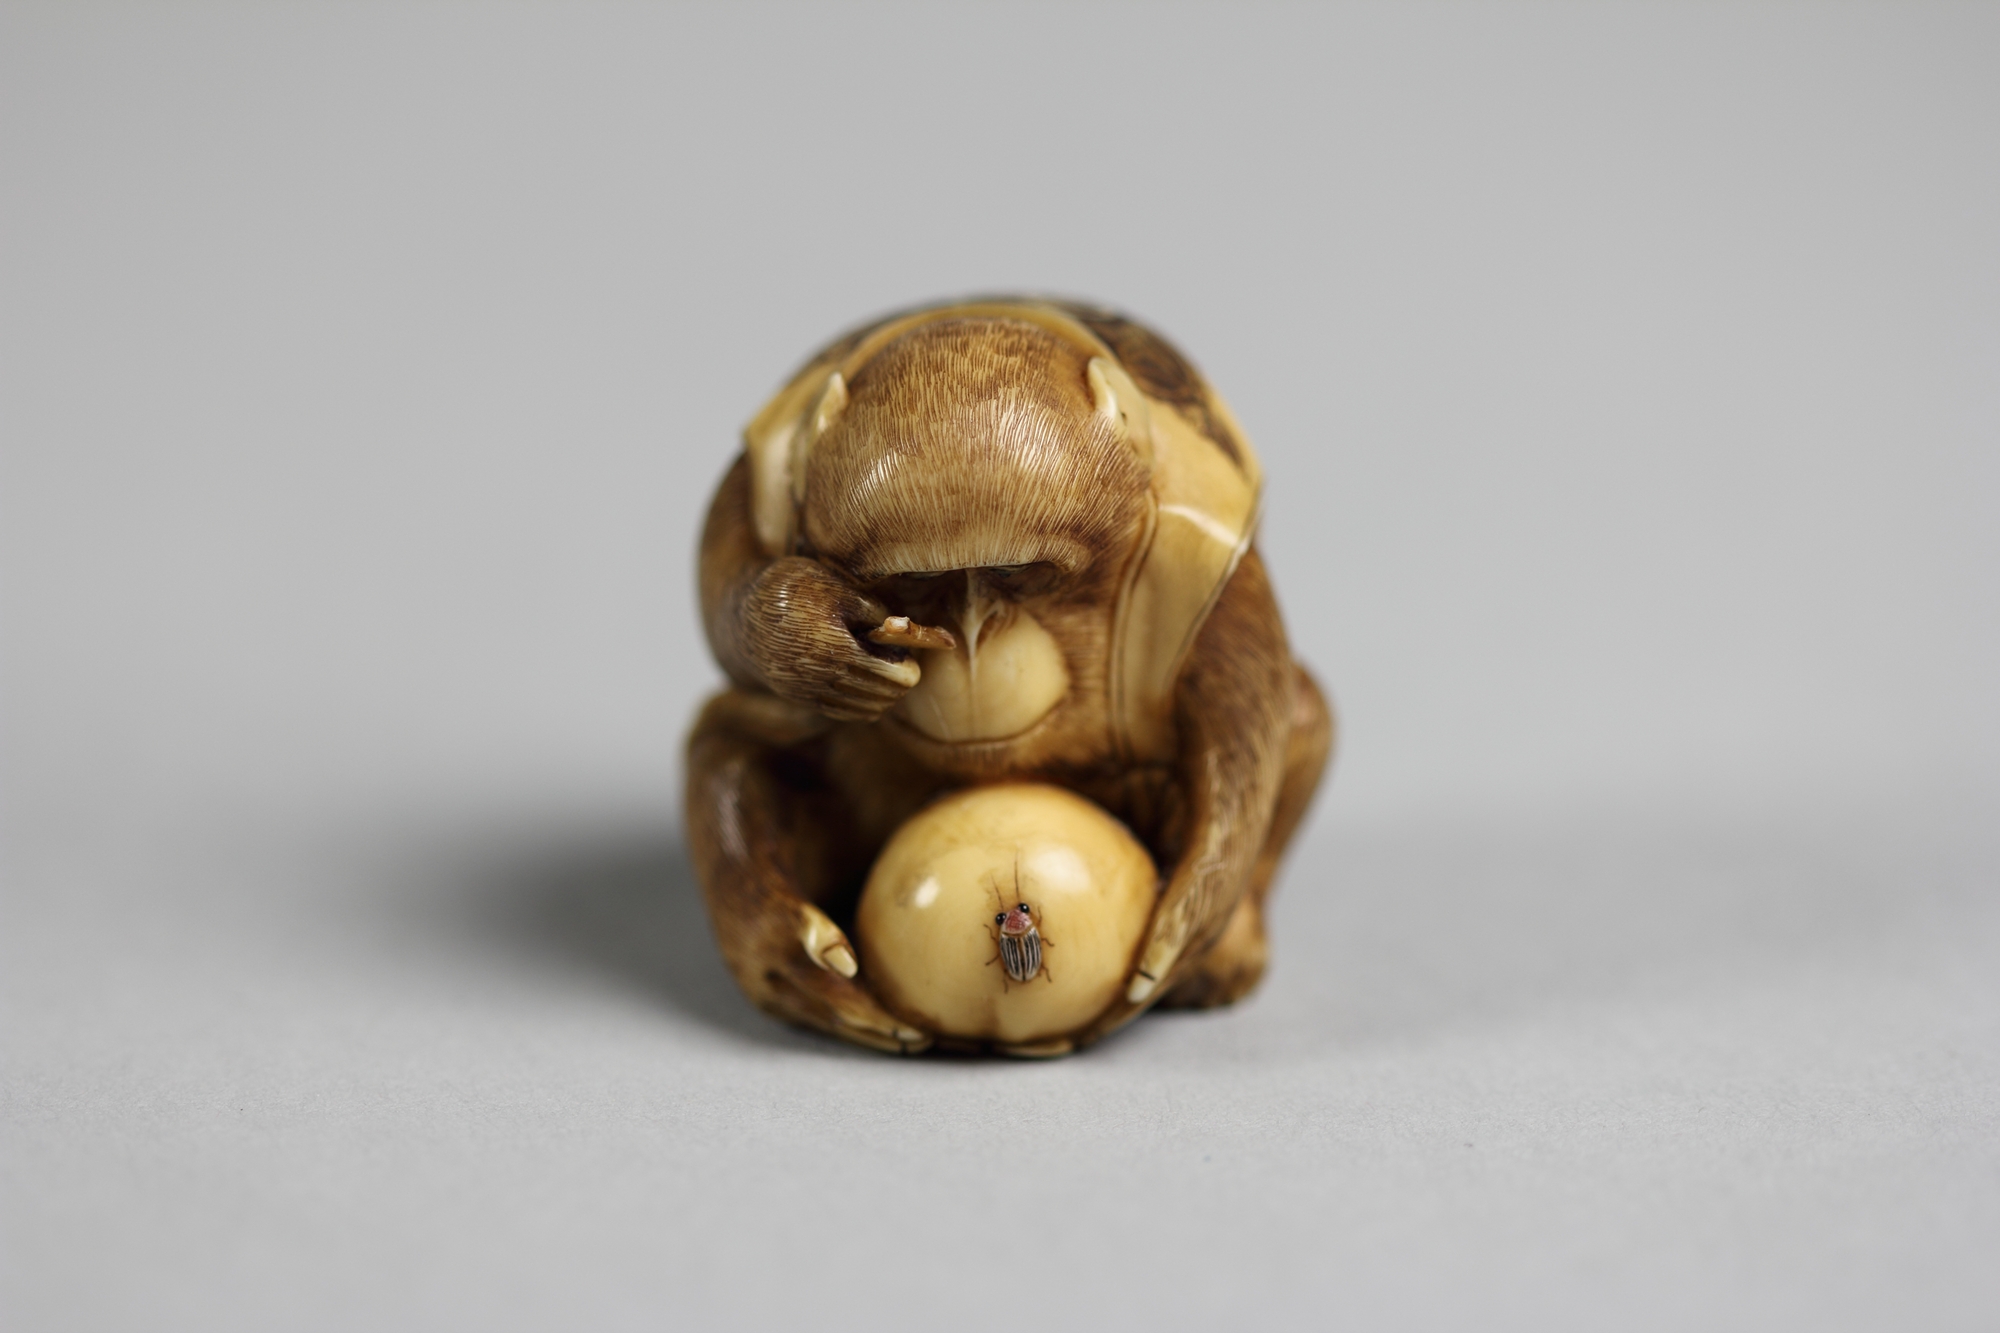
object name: netsuke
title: Netsuke of Monkey Looking at a Fly through a Magnifying Glass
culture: japanese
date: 1801-1900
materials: ivory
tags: insects